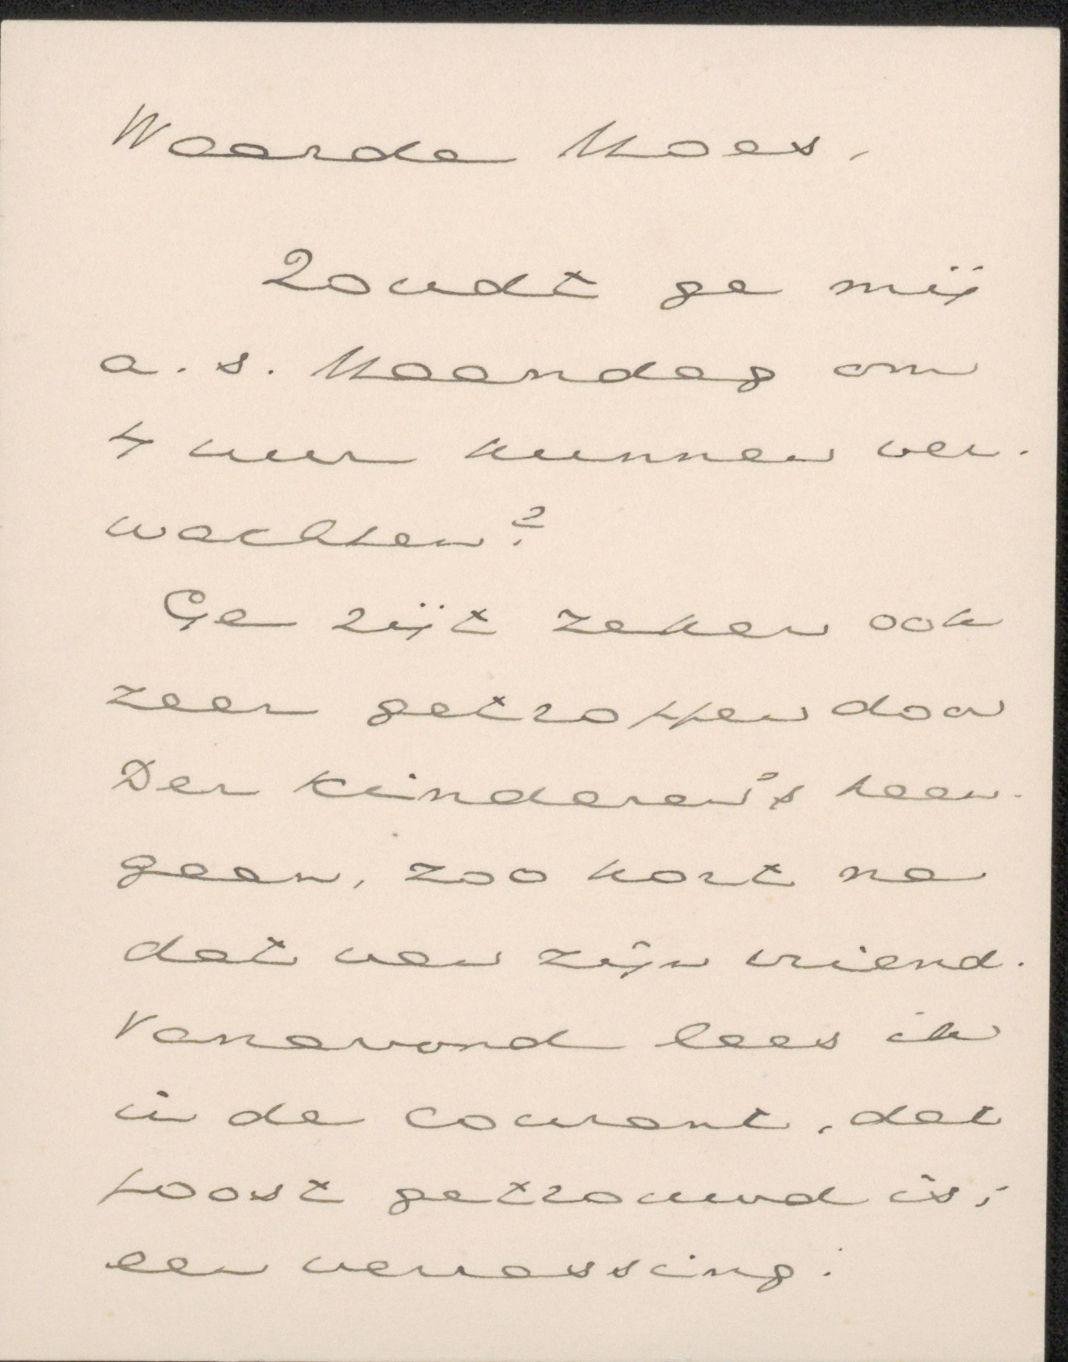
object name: letter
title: Brief aan Christiaan Moes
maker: johan huizinga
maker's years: 1872-1945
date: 1925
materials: ink, paper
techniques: pen, writing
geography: leiden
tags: den bosch, painter, print maker, draughtsman, antoon derkinderen, engineer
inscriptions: collector's mark: ‘RPK’